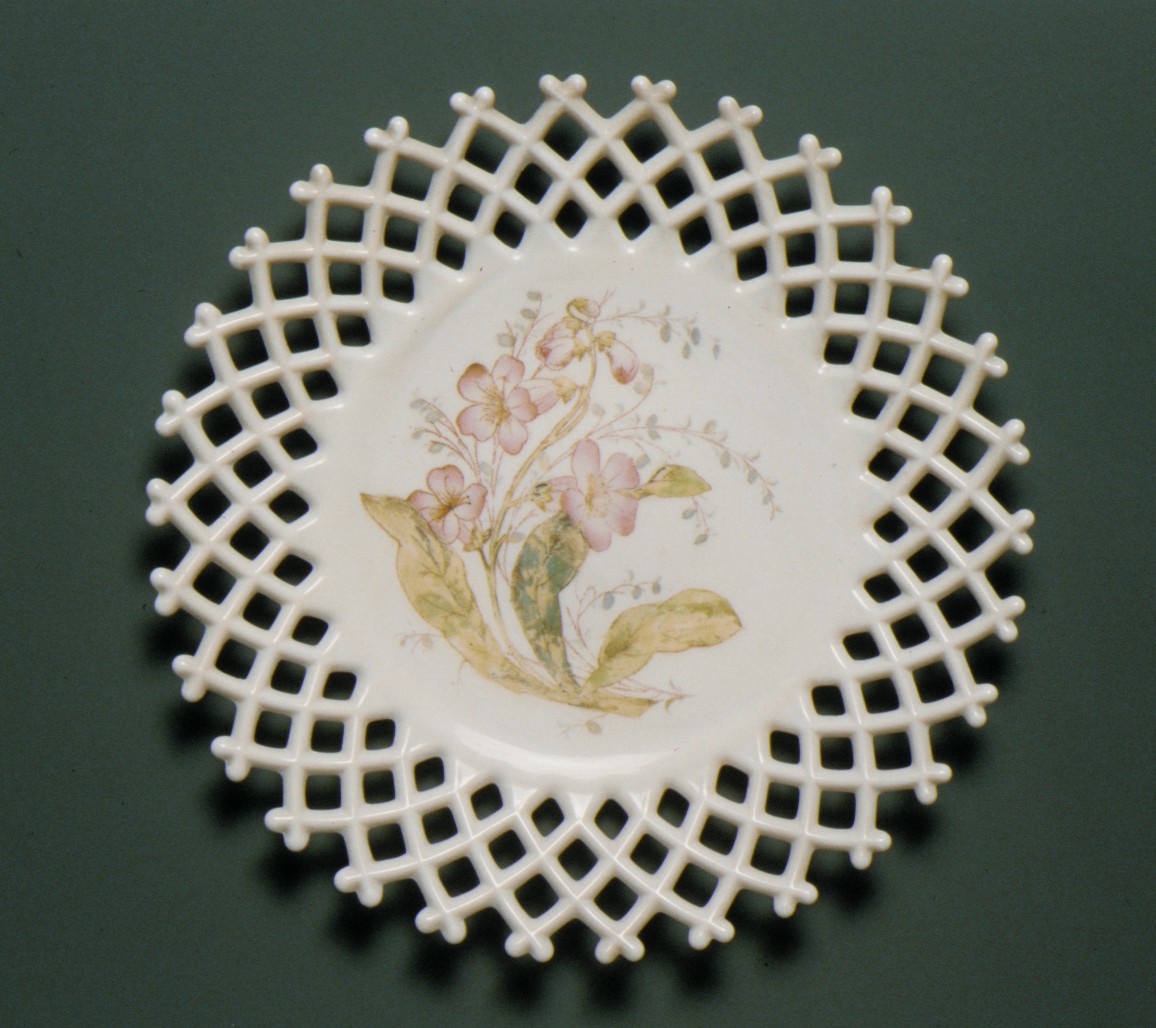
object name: plate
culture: american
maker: challinor, taylor and company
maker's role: maker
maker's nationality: american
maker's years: 1866-1891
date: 1886-1895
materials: glass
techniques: pressed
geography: united states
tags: flowers